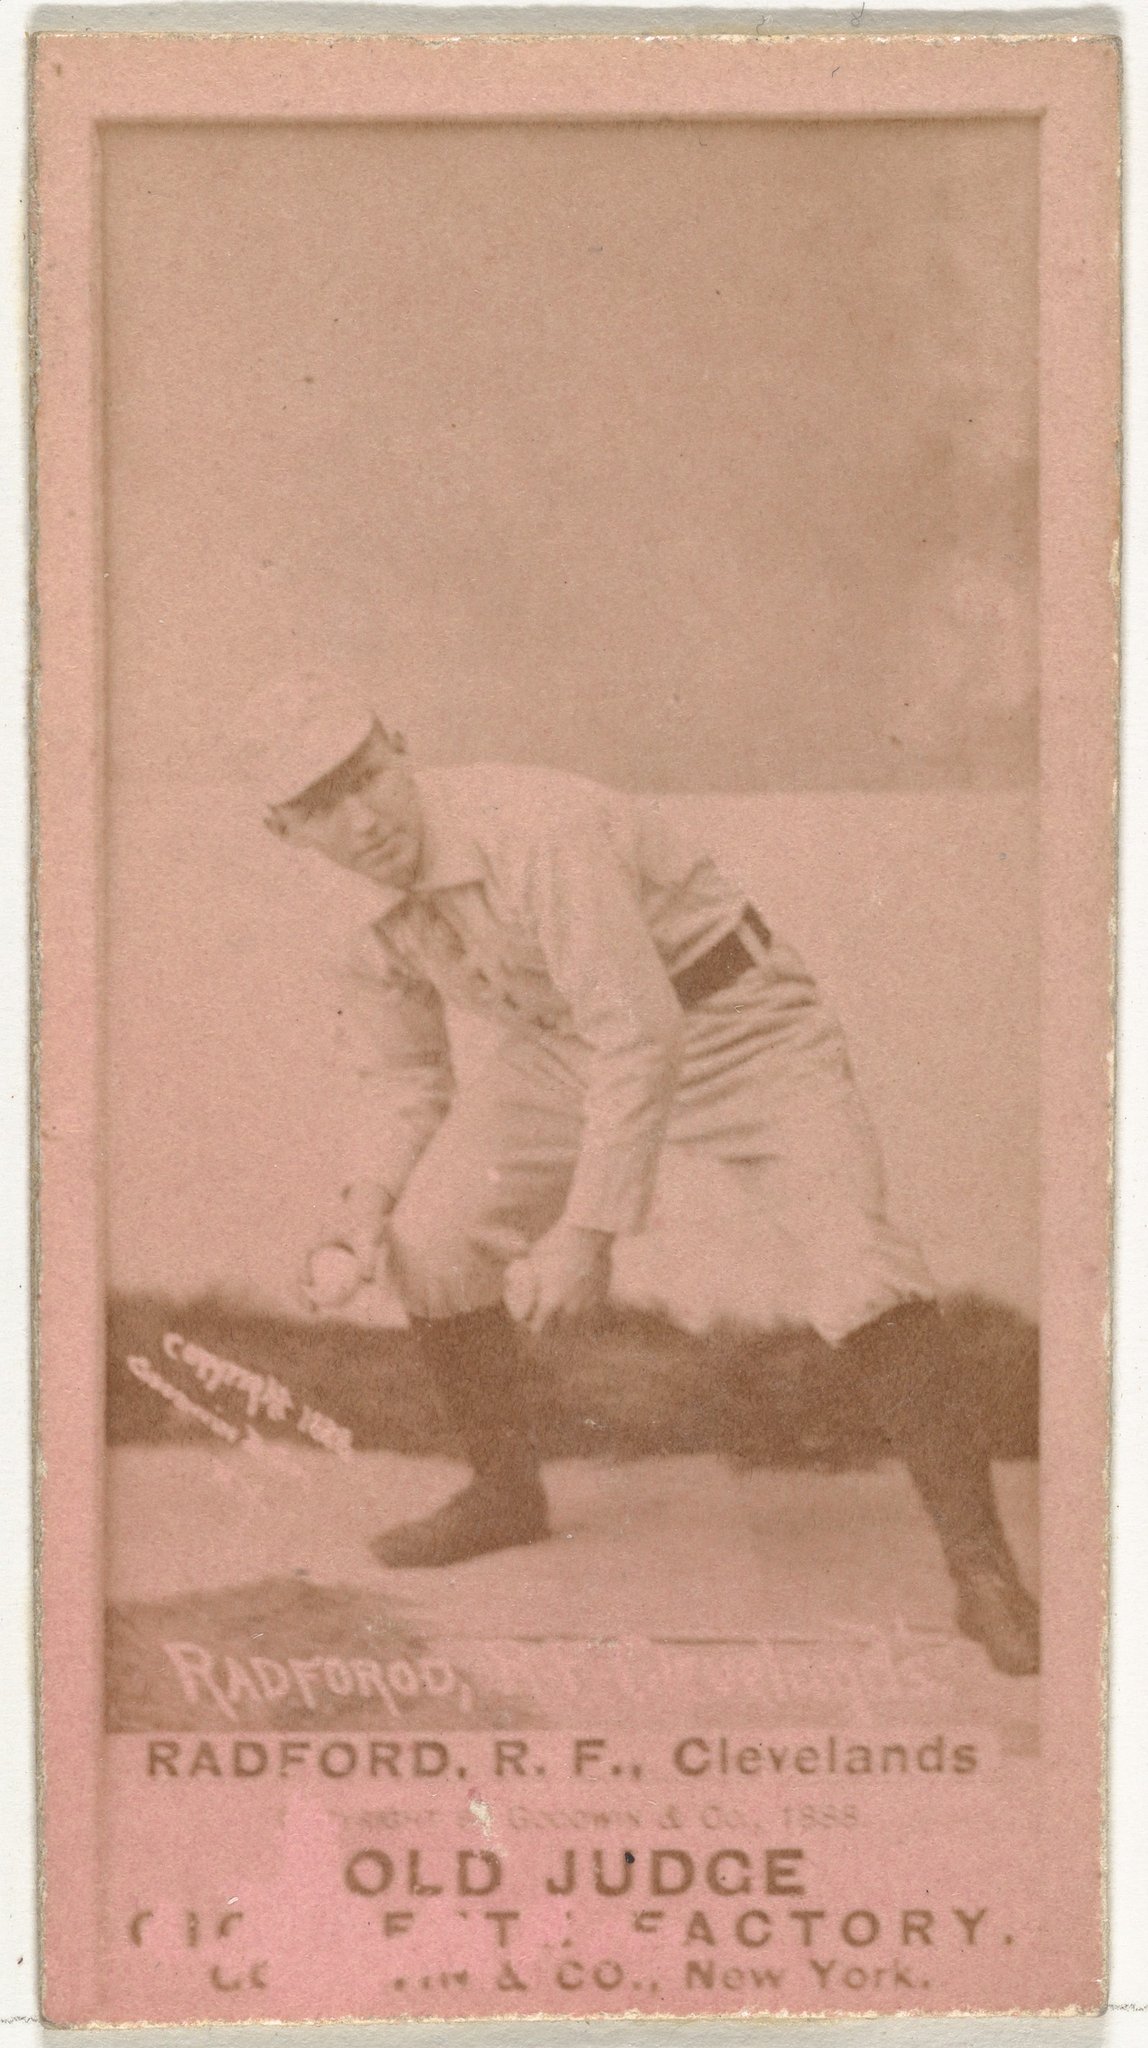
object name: baseball card, photograph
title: Paul Revere "Shorty" Radford, Right Field, Cleveland, from the Old Judge series (N172) for Old Judge Cigarettes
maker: goodwin & company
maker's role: publisher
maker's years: 1850-1950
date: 1888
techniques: albumen silver print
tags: men,portraits,baseball,athletes